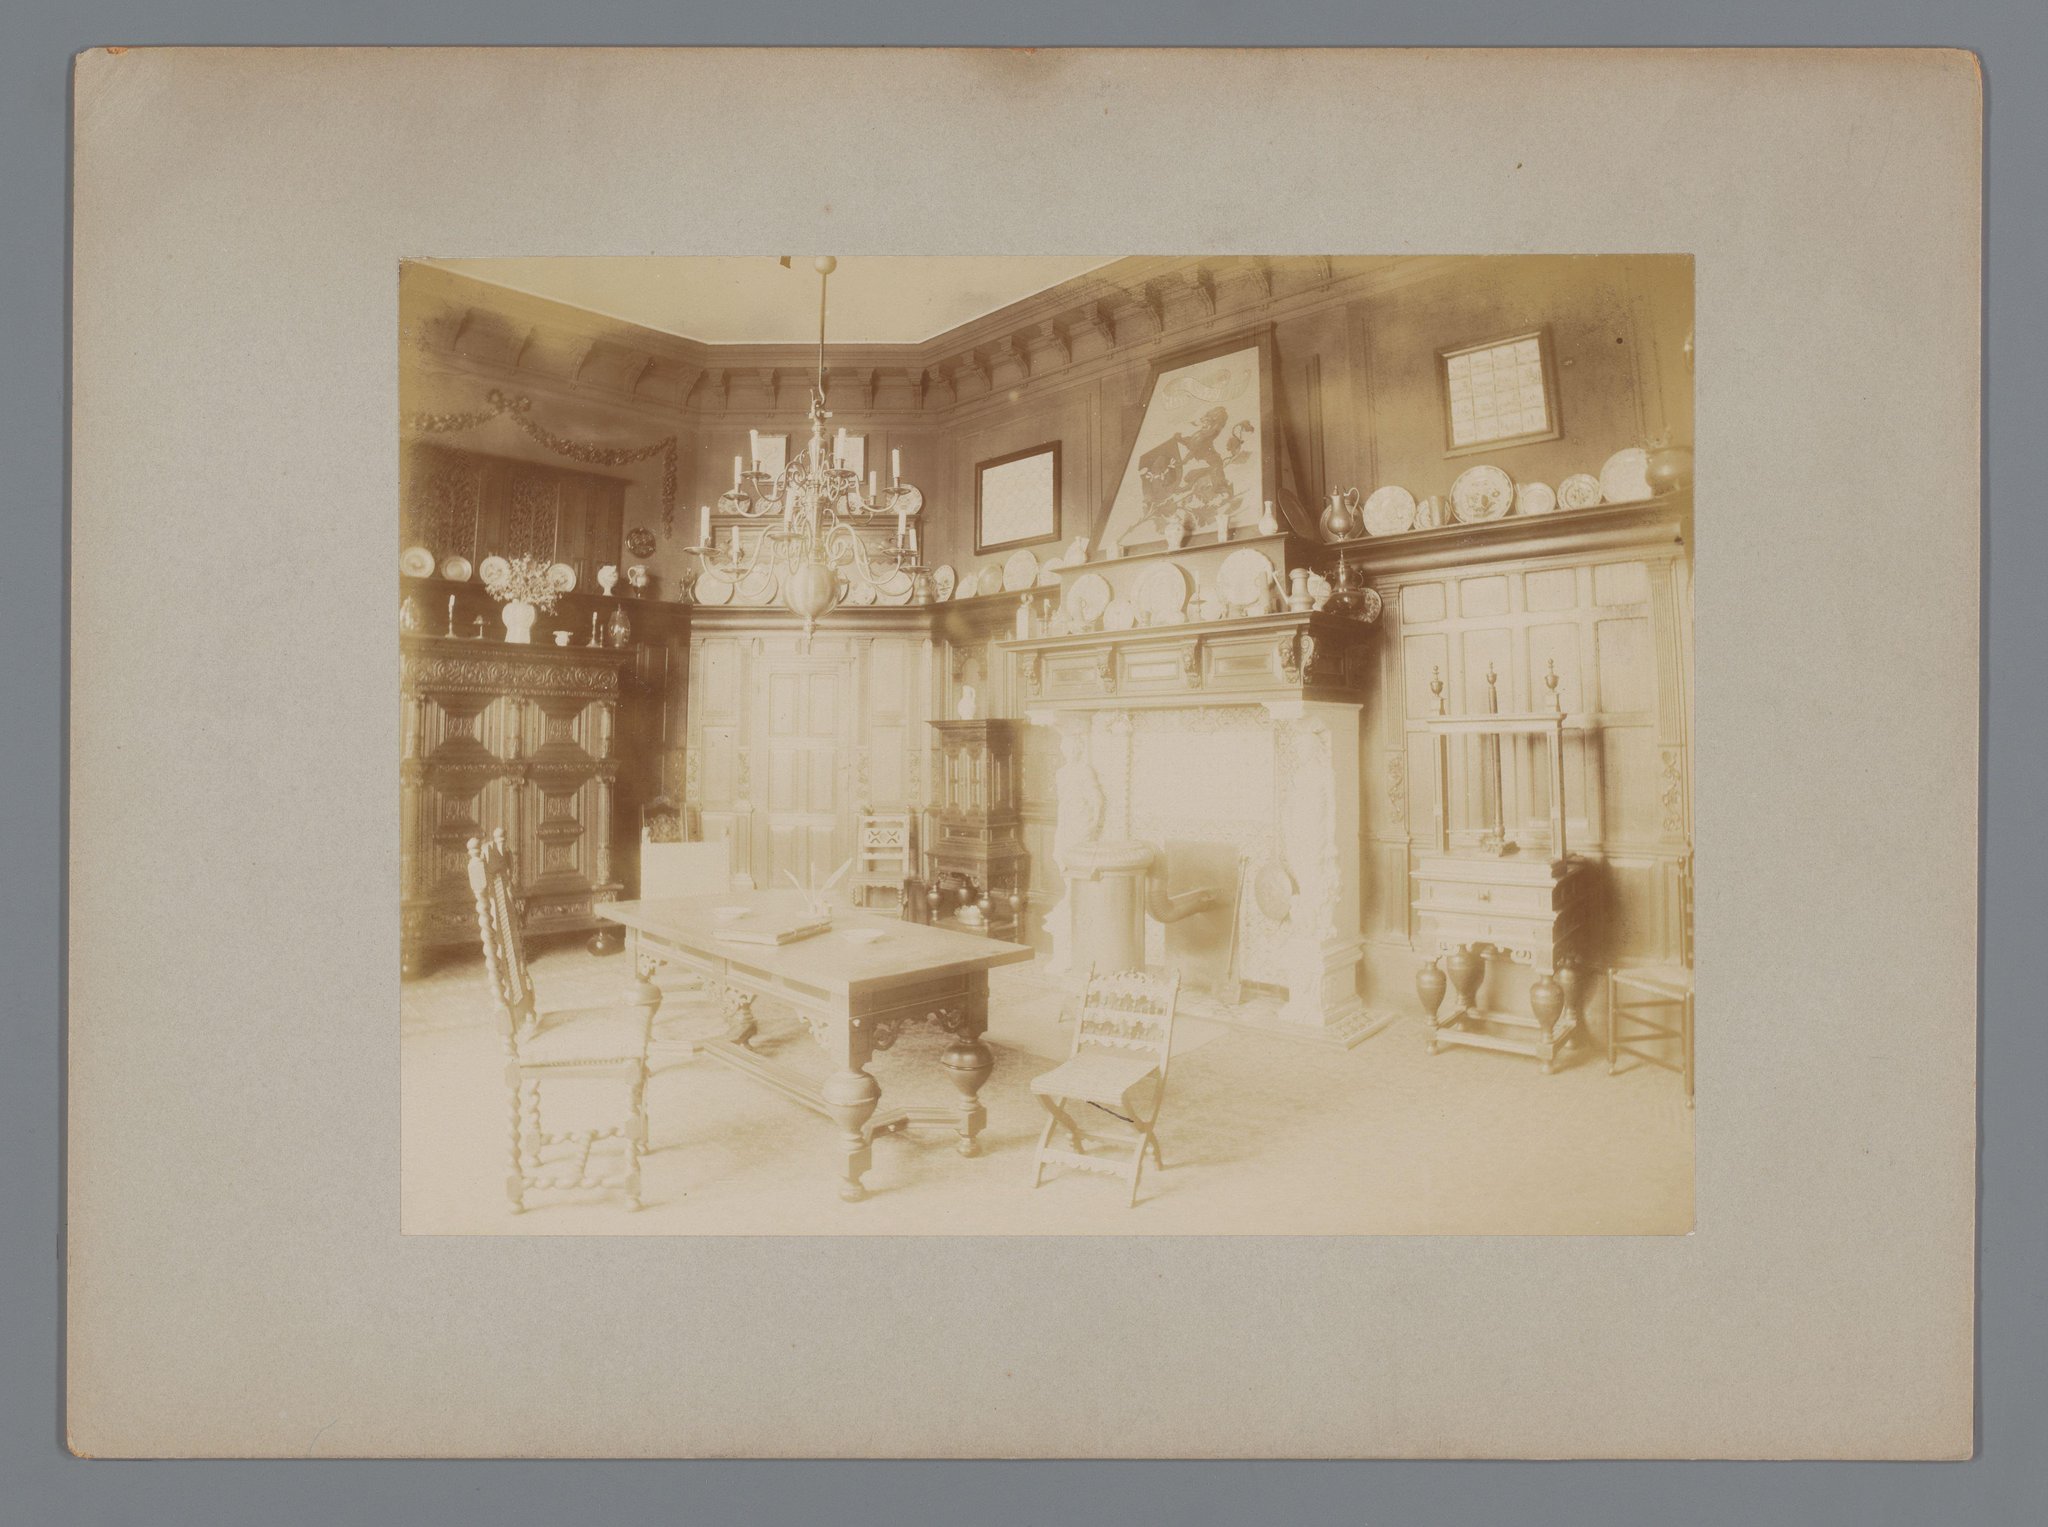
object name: photograph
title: Interieur met een bureau, stoelen en sierborden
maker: johann pörtzgen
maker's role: fotograaf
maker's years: 1857-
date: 1890-1900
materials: cardboard, photographic support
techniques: collodion silver print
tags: chandelier, candelabrum, interior of the house, chair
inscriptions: workshop stamp: ‘J. Pörtzgen/ Photograaf/ Koningstraat 38/ Haarlem’, collector's mark: ‘Museum van Kunst-Nijverheid Haarlem’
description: Dit albumblad maakt deel uit van een omslag met 6 bladen.